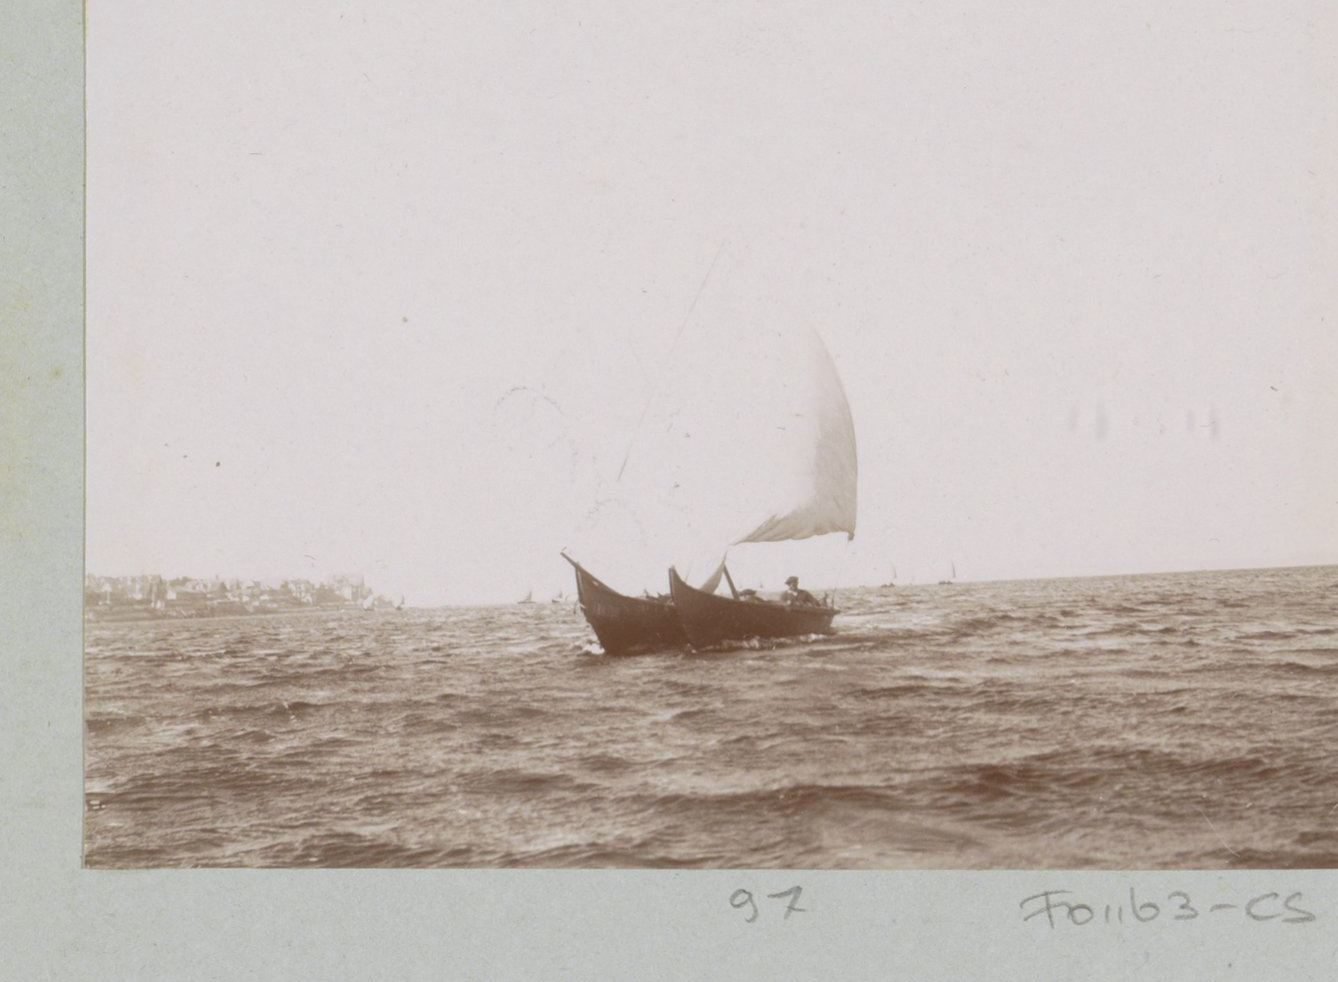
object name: photograph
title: Twee zeilboten op zee, vermoedelijk ter hoogte van Le Moulleau bij Arcachon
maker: delizy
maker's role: manufacturer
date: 1803-1897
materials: paper, photographic support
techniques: gelatin silver print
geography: arcachon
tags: sailing-ship, sailing-boat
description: Onderdeel van Fotoalbum van een Franse amateurfotograaf met opnames van uitstapjes in Frankrijk, Spanje, België, Luxemburg en Nederland, de eerste automobielen en autoraces.